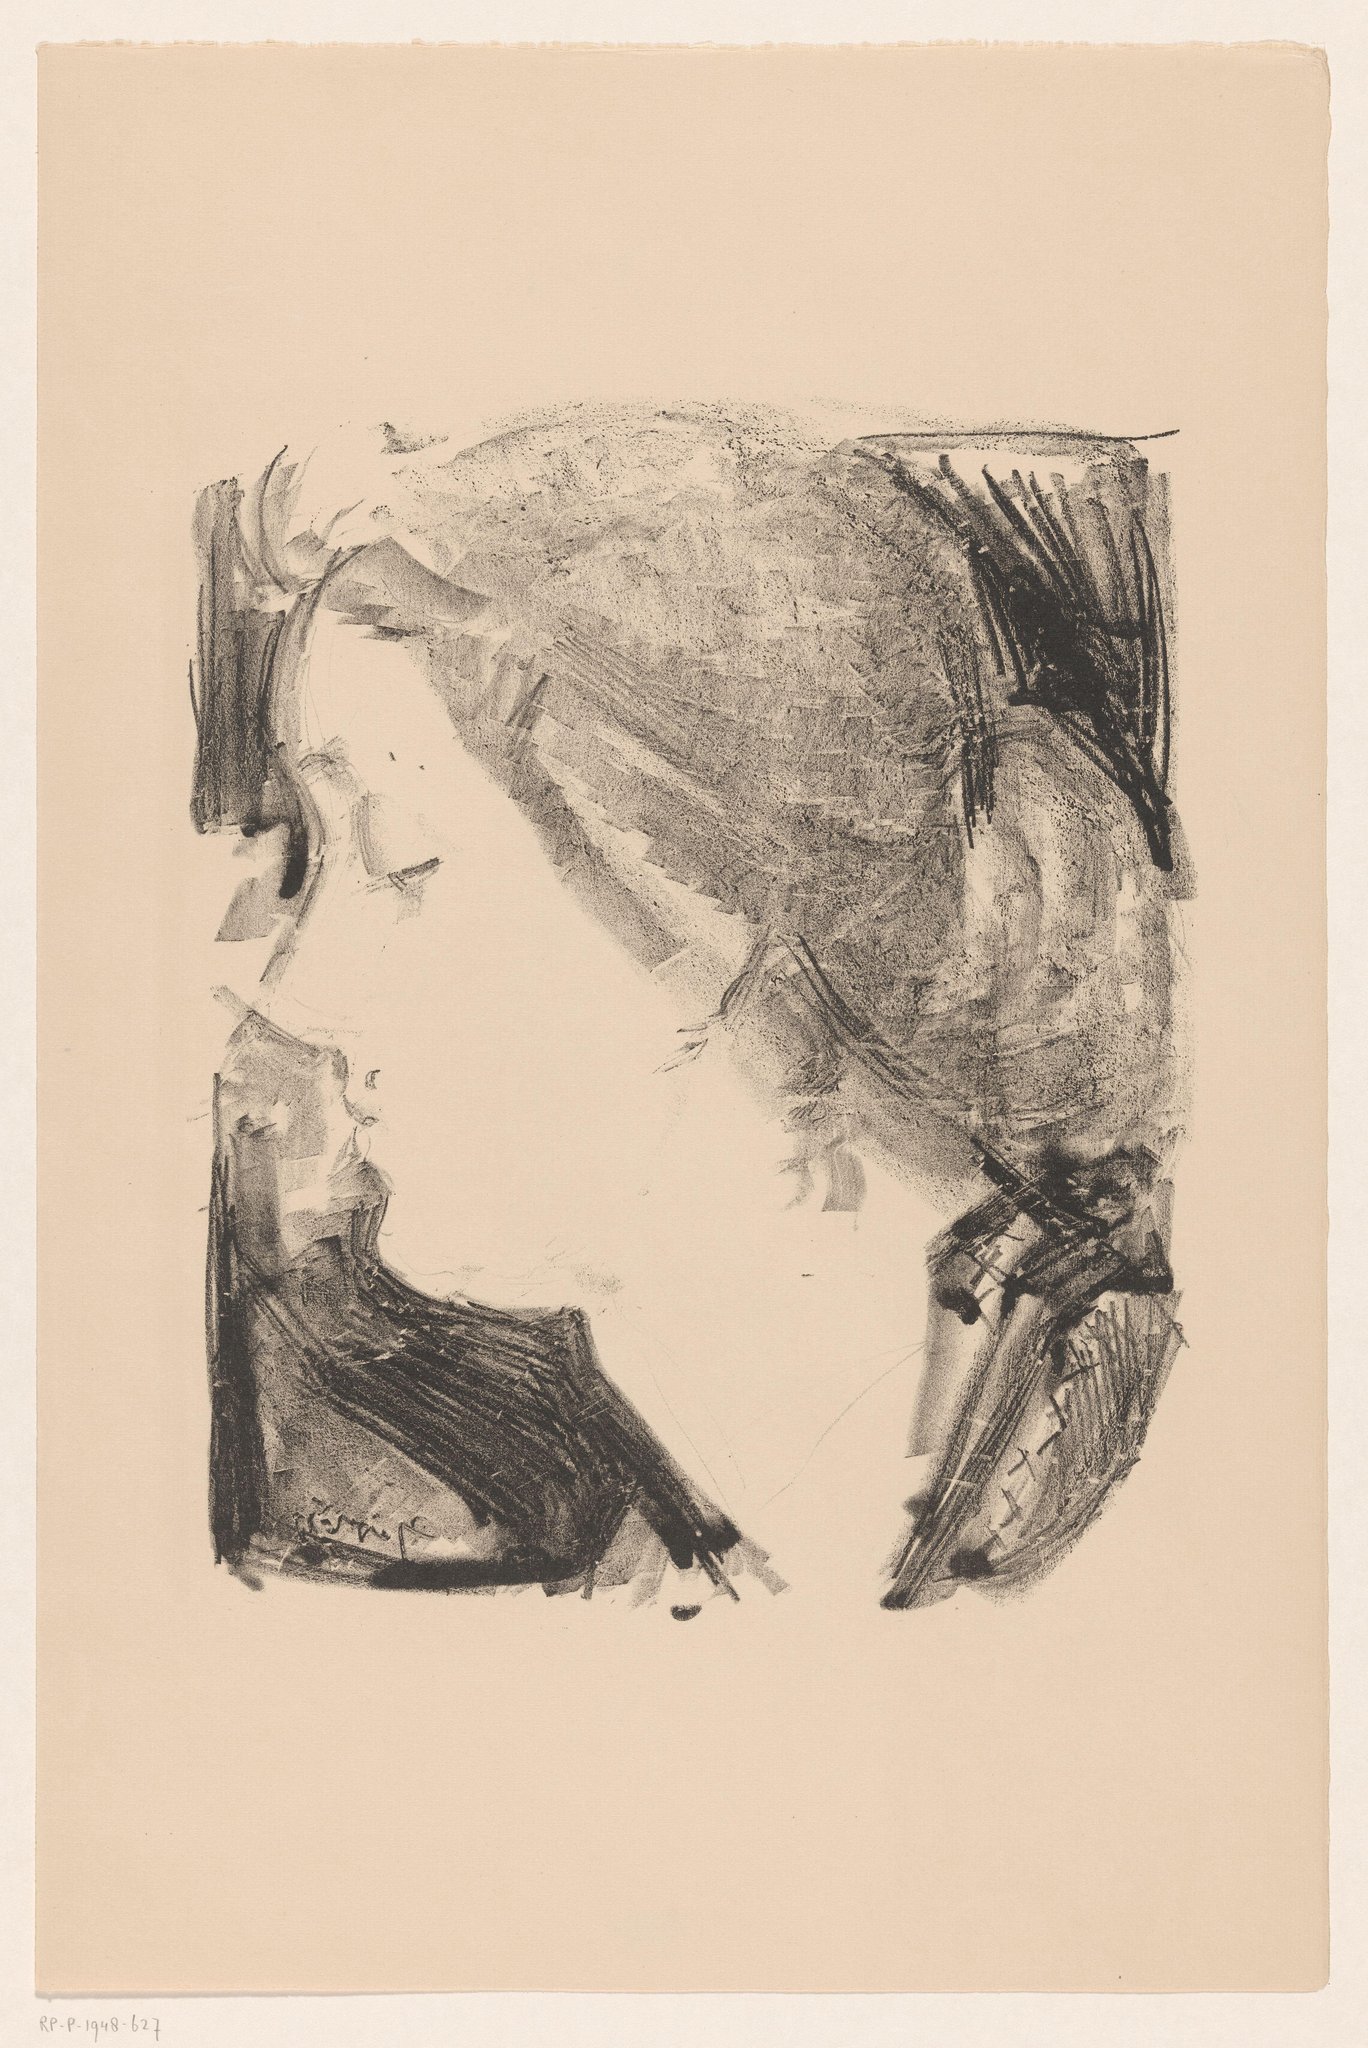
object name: print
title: Portret van Coba Stolk-Schmidt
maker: reijer stolk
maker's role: draughtsman, print maker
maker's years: 1896-1945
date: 1906-1945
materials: paper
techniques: lithograph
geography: netherlands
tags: historical persons - bb - woman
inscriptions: collector's mark: Lugt 2228